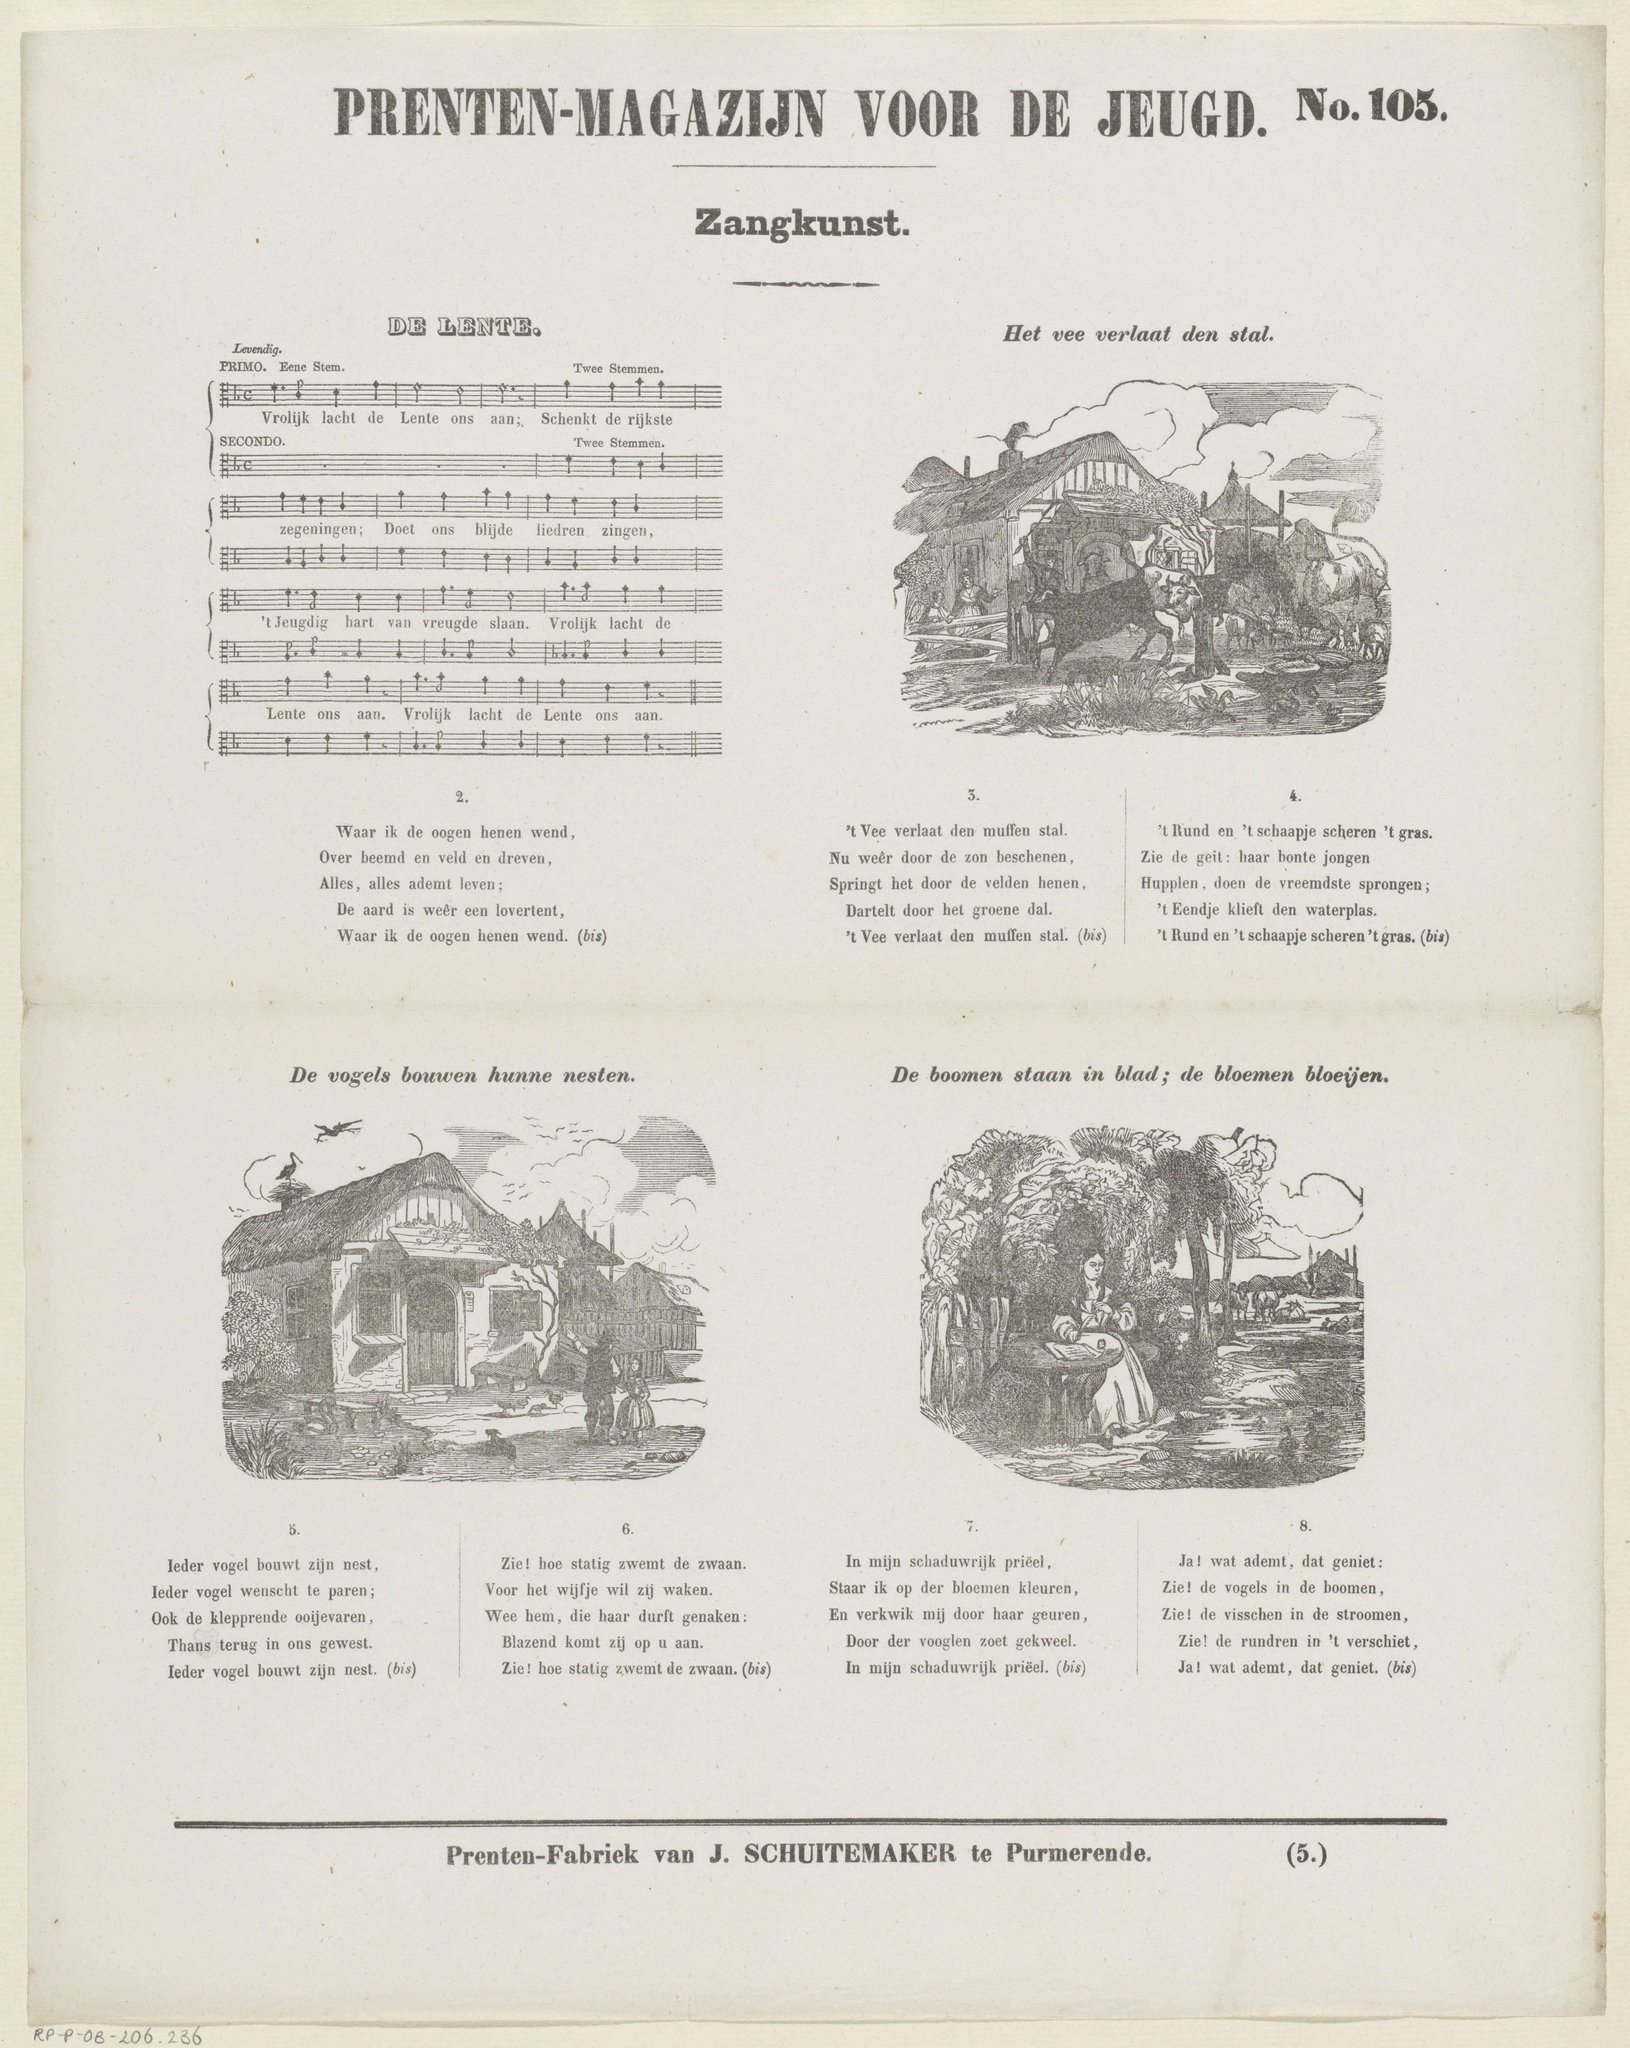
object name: print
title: Lente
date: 1850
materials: paper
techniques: letterpress printing, engraving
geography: purmerend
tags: seasons of the year represented by concepts other than personifications, human activities, landscapes, or still lifes of flowers and/or fruits (e.g. biblical scenes), spring ~ human activities (the four seasons of the year)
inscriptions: collector's mark: Lugt 2760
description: Na voltooiing van de acht jaargangen van de reeks 'Prenten-magazijn voor de jeugd' in 1850 heeft Jan Schuitemaker al deze prenten heruitgegeven en omgenummerd als nr. 1 t/m 192. De oorspronkelijke jaargang wordt telkens nog vermeld rechtsonder op de prent. Binnen de jaargangen zijn prenten van hetzelfde thema in clusters van vier achter elkaar gezet.